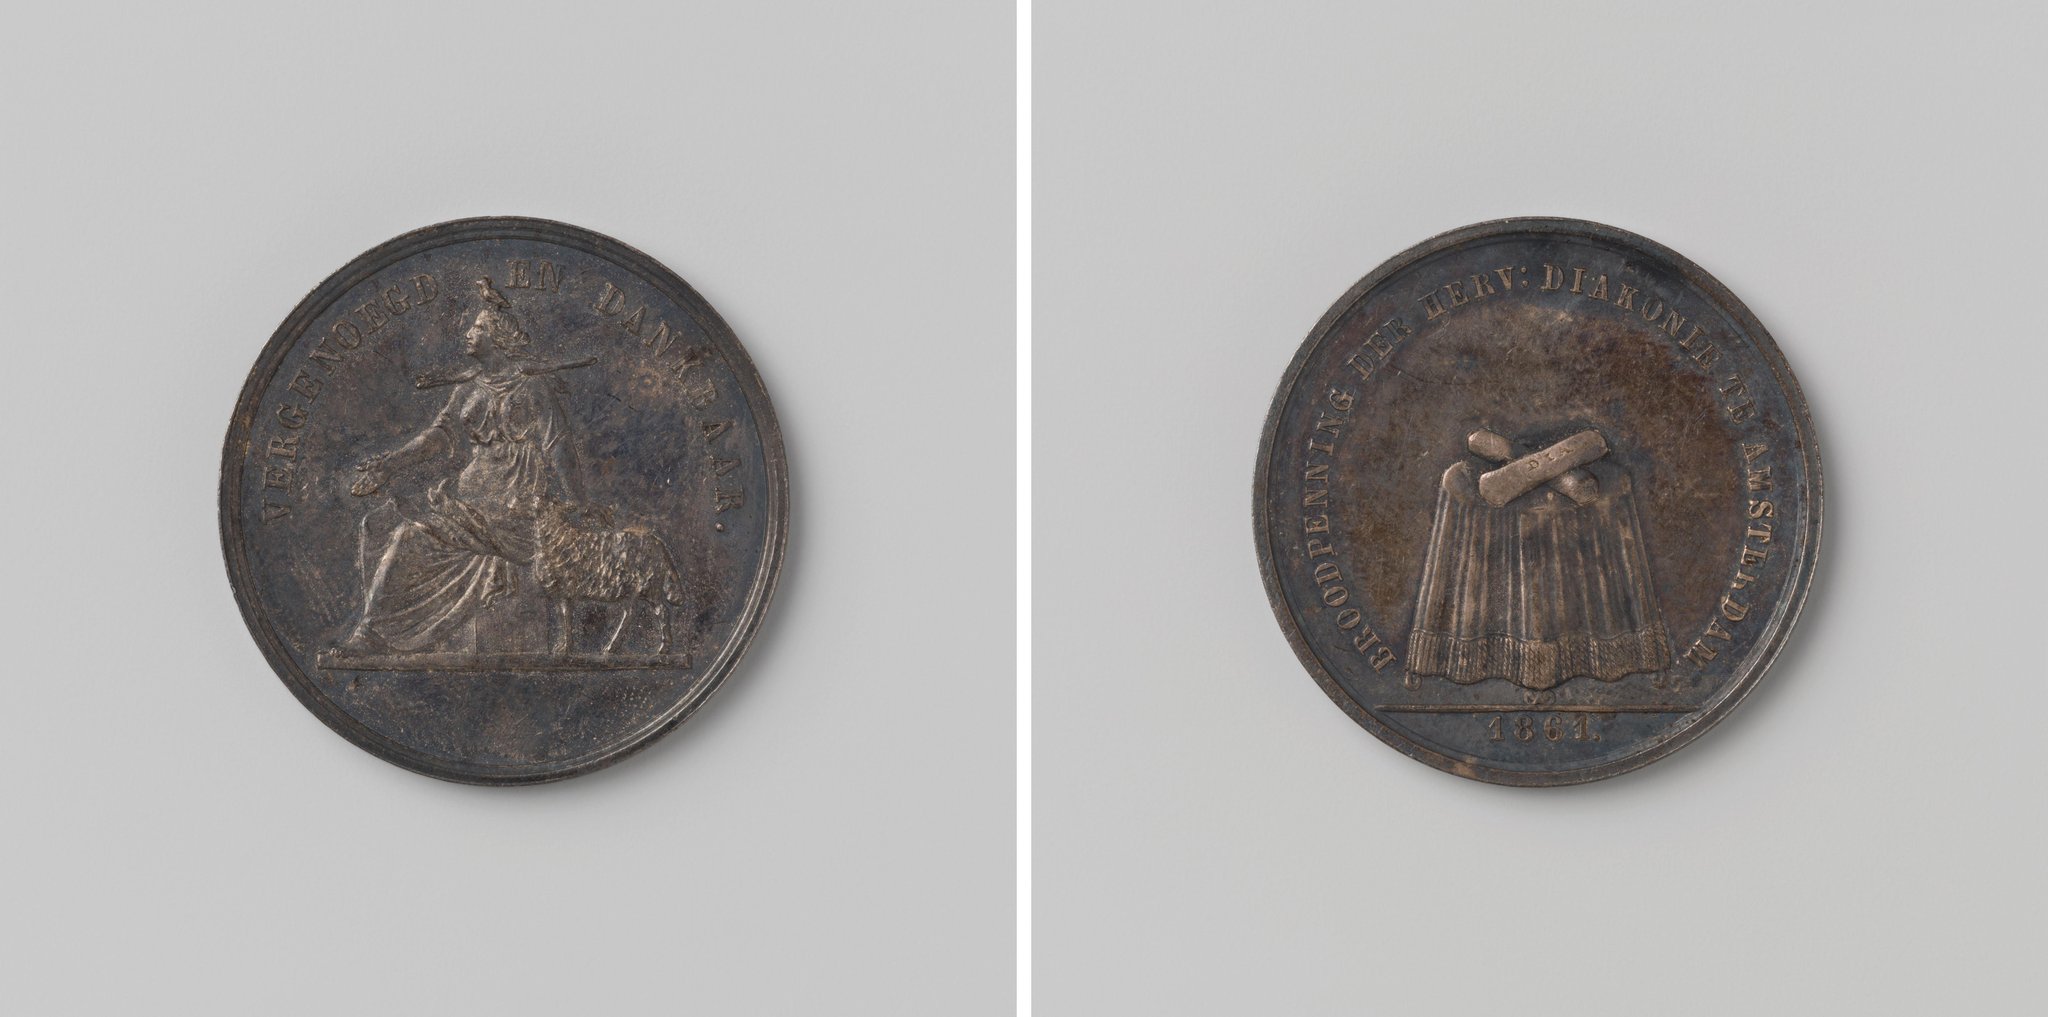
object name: medal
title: Hervormde Diakonie te Amsterdam, penning in de vorm van een armenpenning, geschonken aan nieuw aangekomen diakenen en diakenessen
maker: david van der kellen (1804-1879)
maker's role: die cutter, draughtsman, print maker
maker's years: 1804-1879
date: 1861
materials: silver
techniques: striking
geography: amsterdam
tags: amsterdam